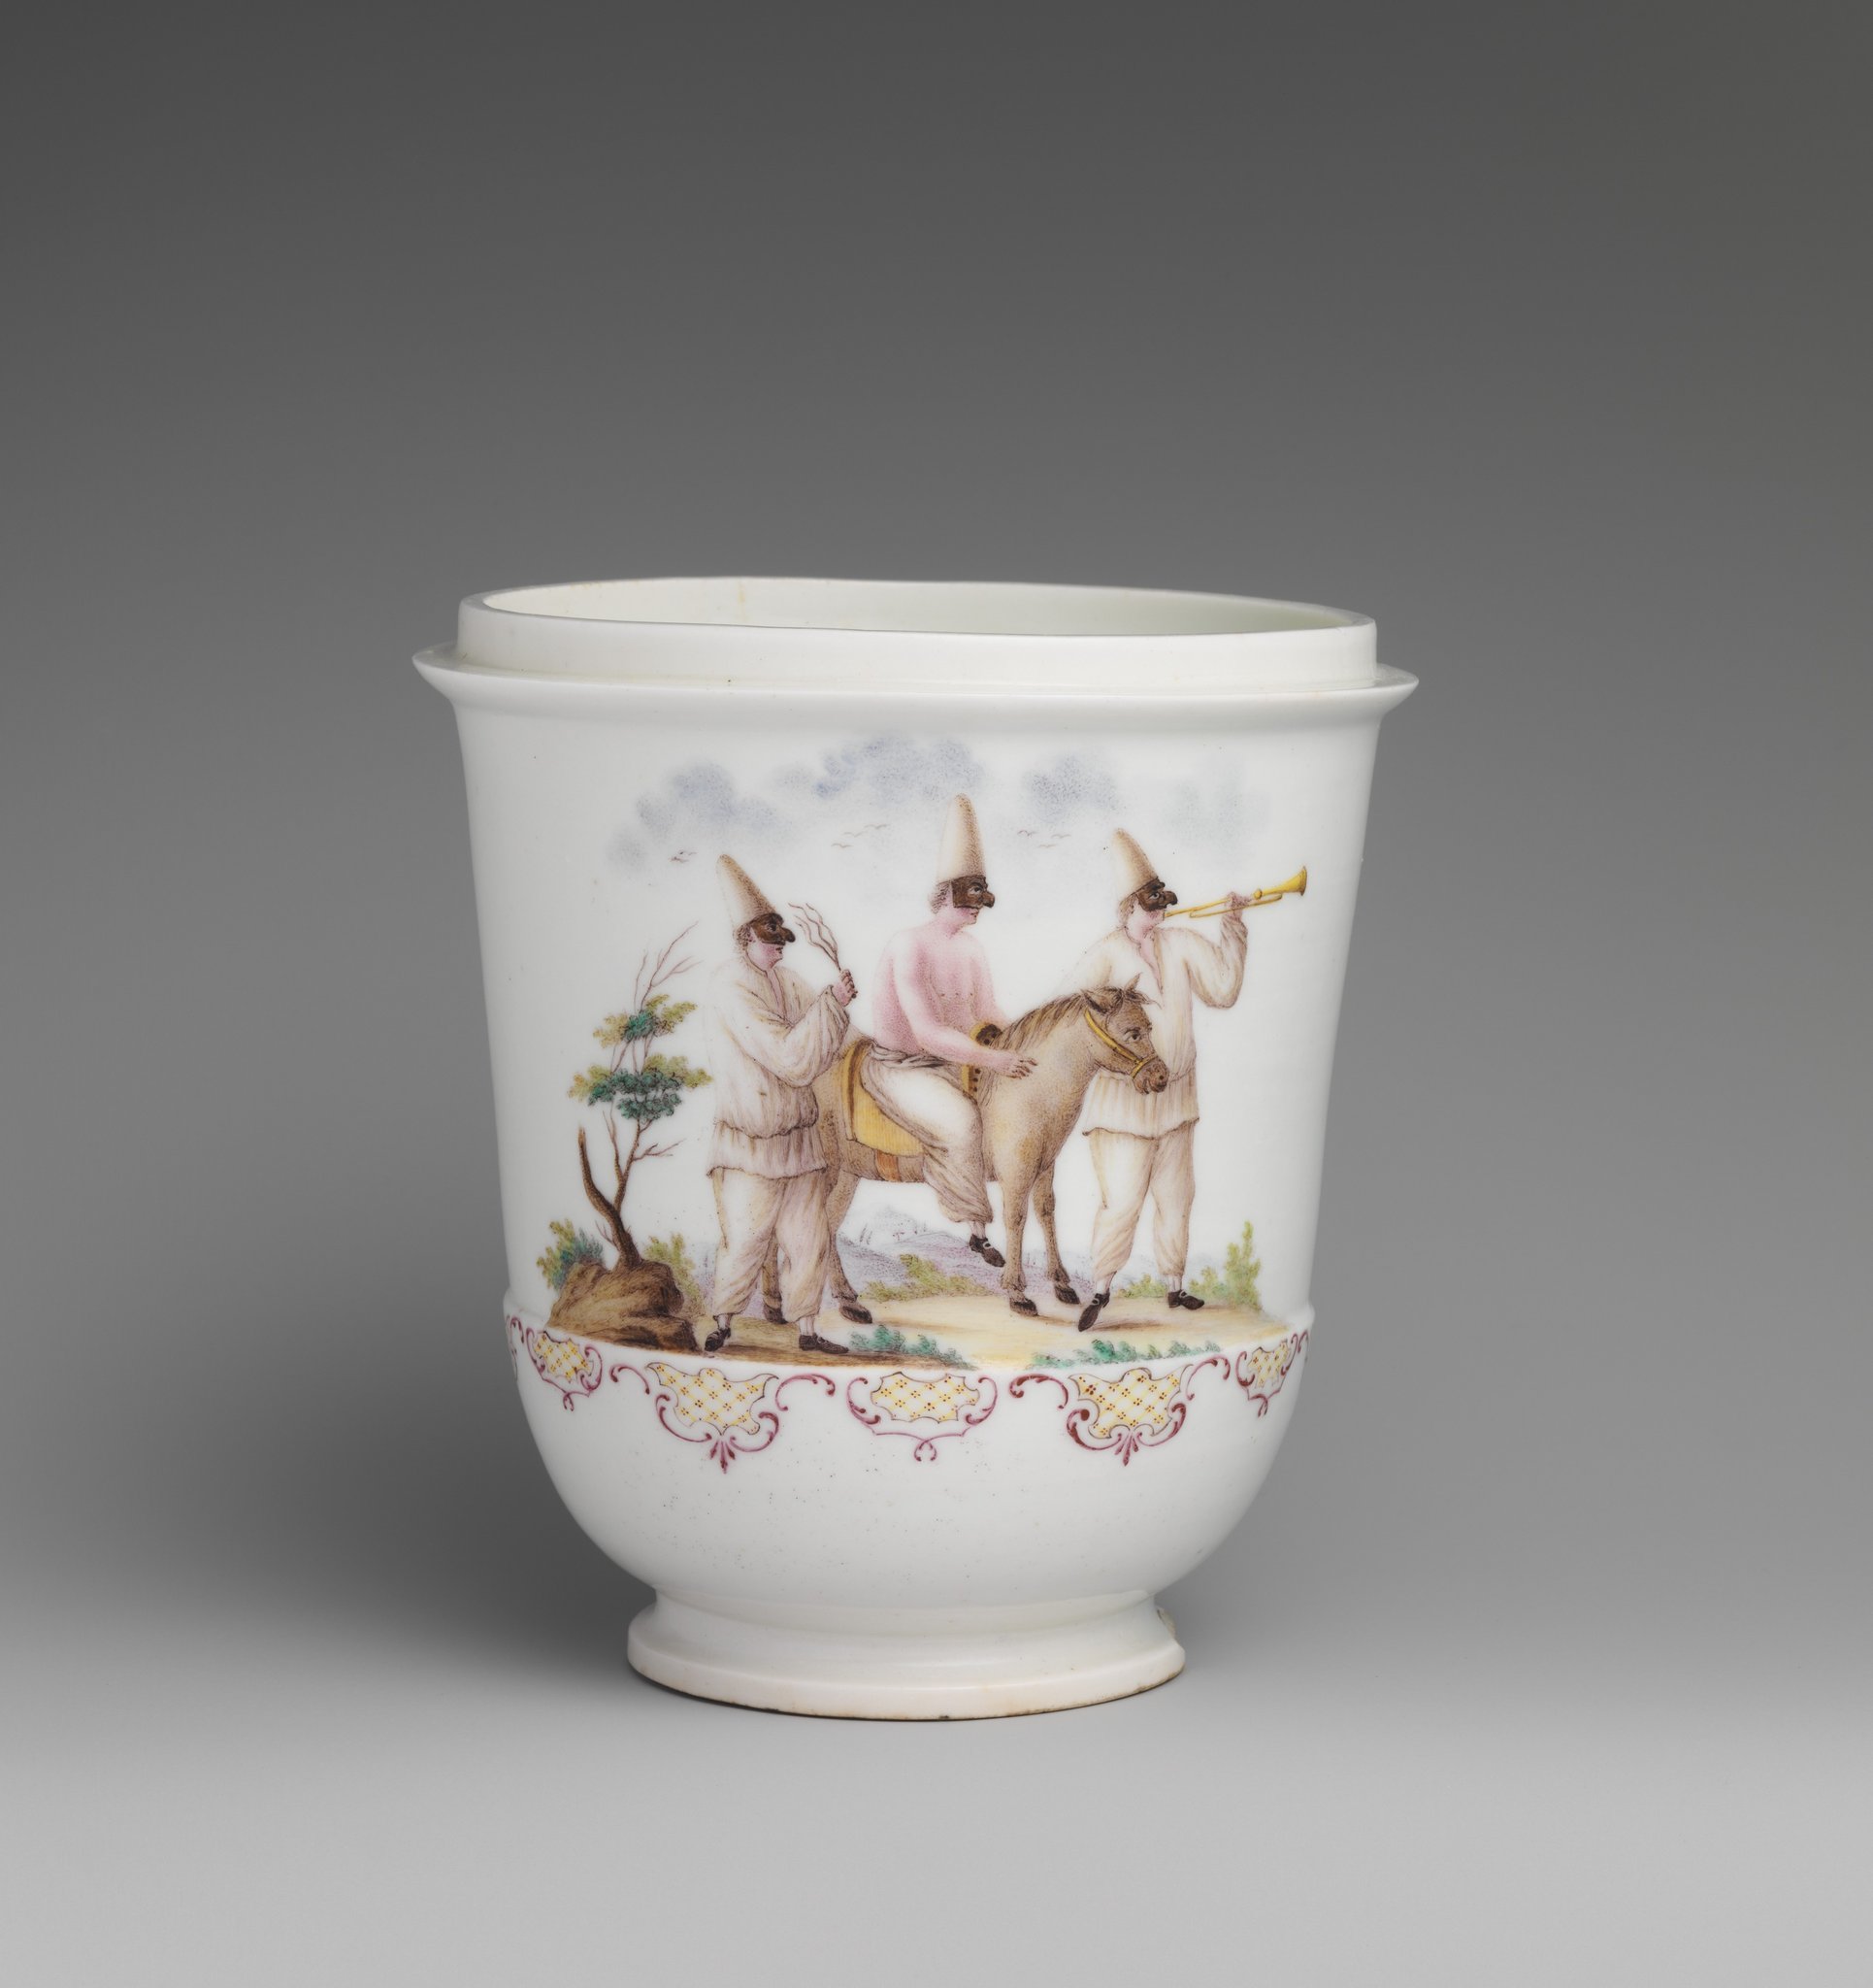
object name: jar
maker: capodimonte porcelain manufactory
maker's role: manufactory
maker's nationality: italian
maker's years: 1740-1759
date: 1750-1760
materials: enamel, soft paste porcelain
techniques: polychrome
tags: men,trumpets,horses